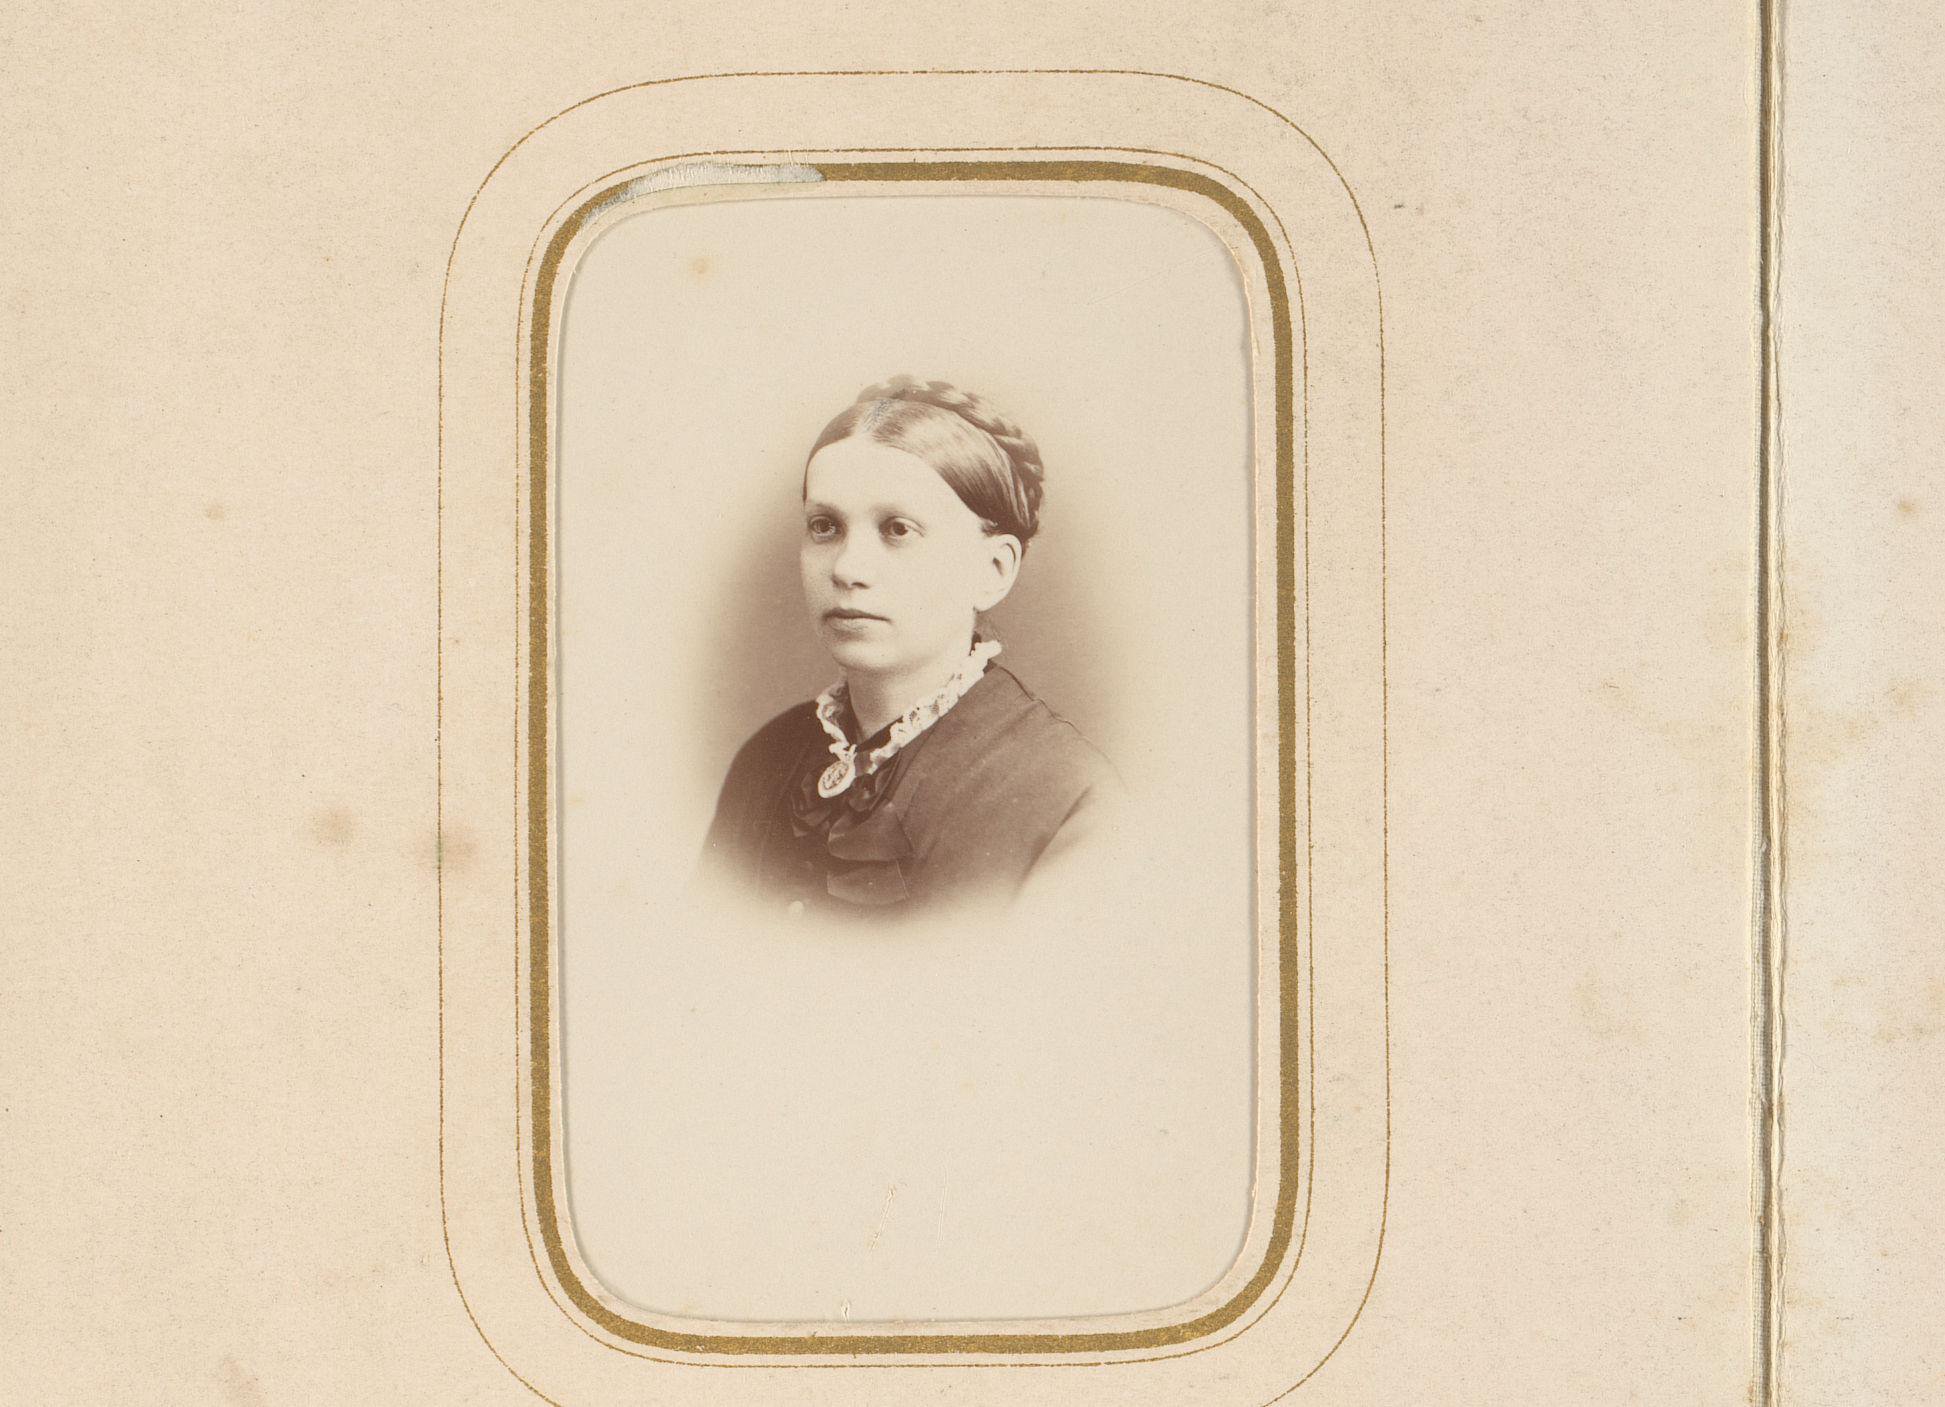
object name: photograph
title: Portret van een vrouw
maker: alphonse bernoud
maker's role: fotograaf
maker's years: 1820-1889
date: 1868-1889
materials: cardboard, photographic support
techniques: albumen print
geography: france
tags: historical persons - bb - woman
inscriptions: inscription: ‘Alphonse Bernoud/ Photographe/ Florence Via dell'Orivolo, 51/ Livourne/ Via Vitt. Emman le 71/ Naples Strada Toledo 256/ Palazzo Berio/ Lyon/ 2, Rue des Archers, 2/ Angle de la Rue St. Dominique’